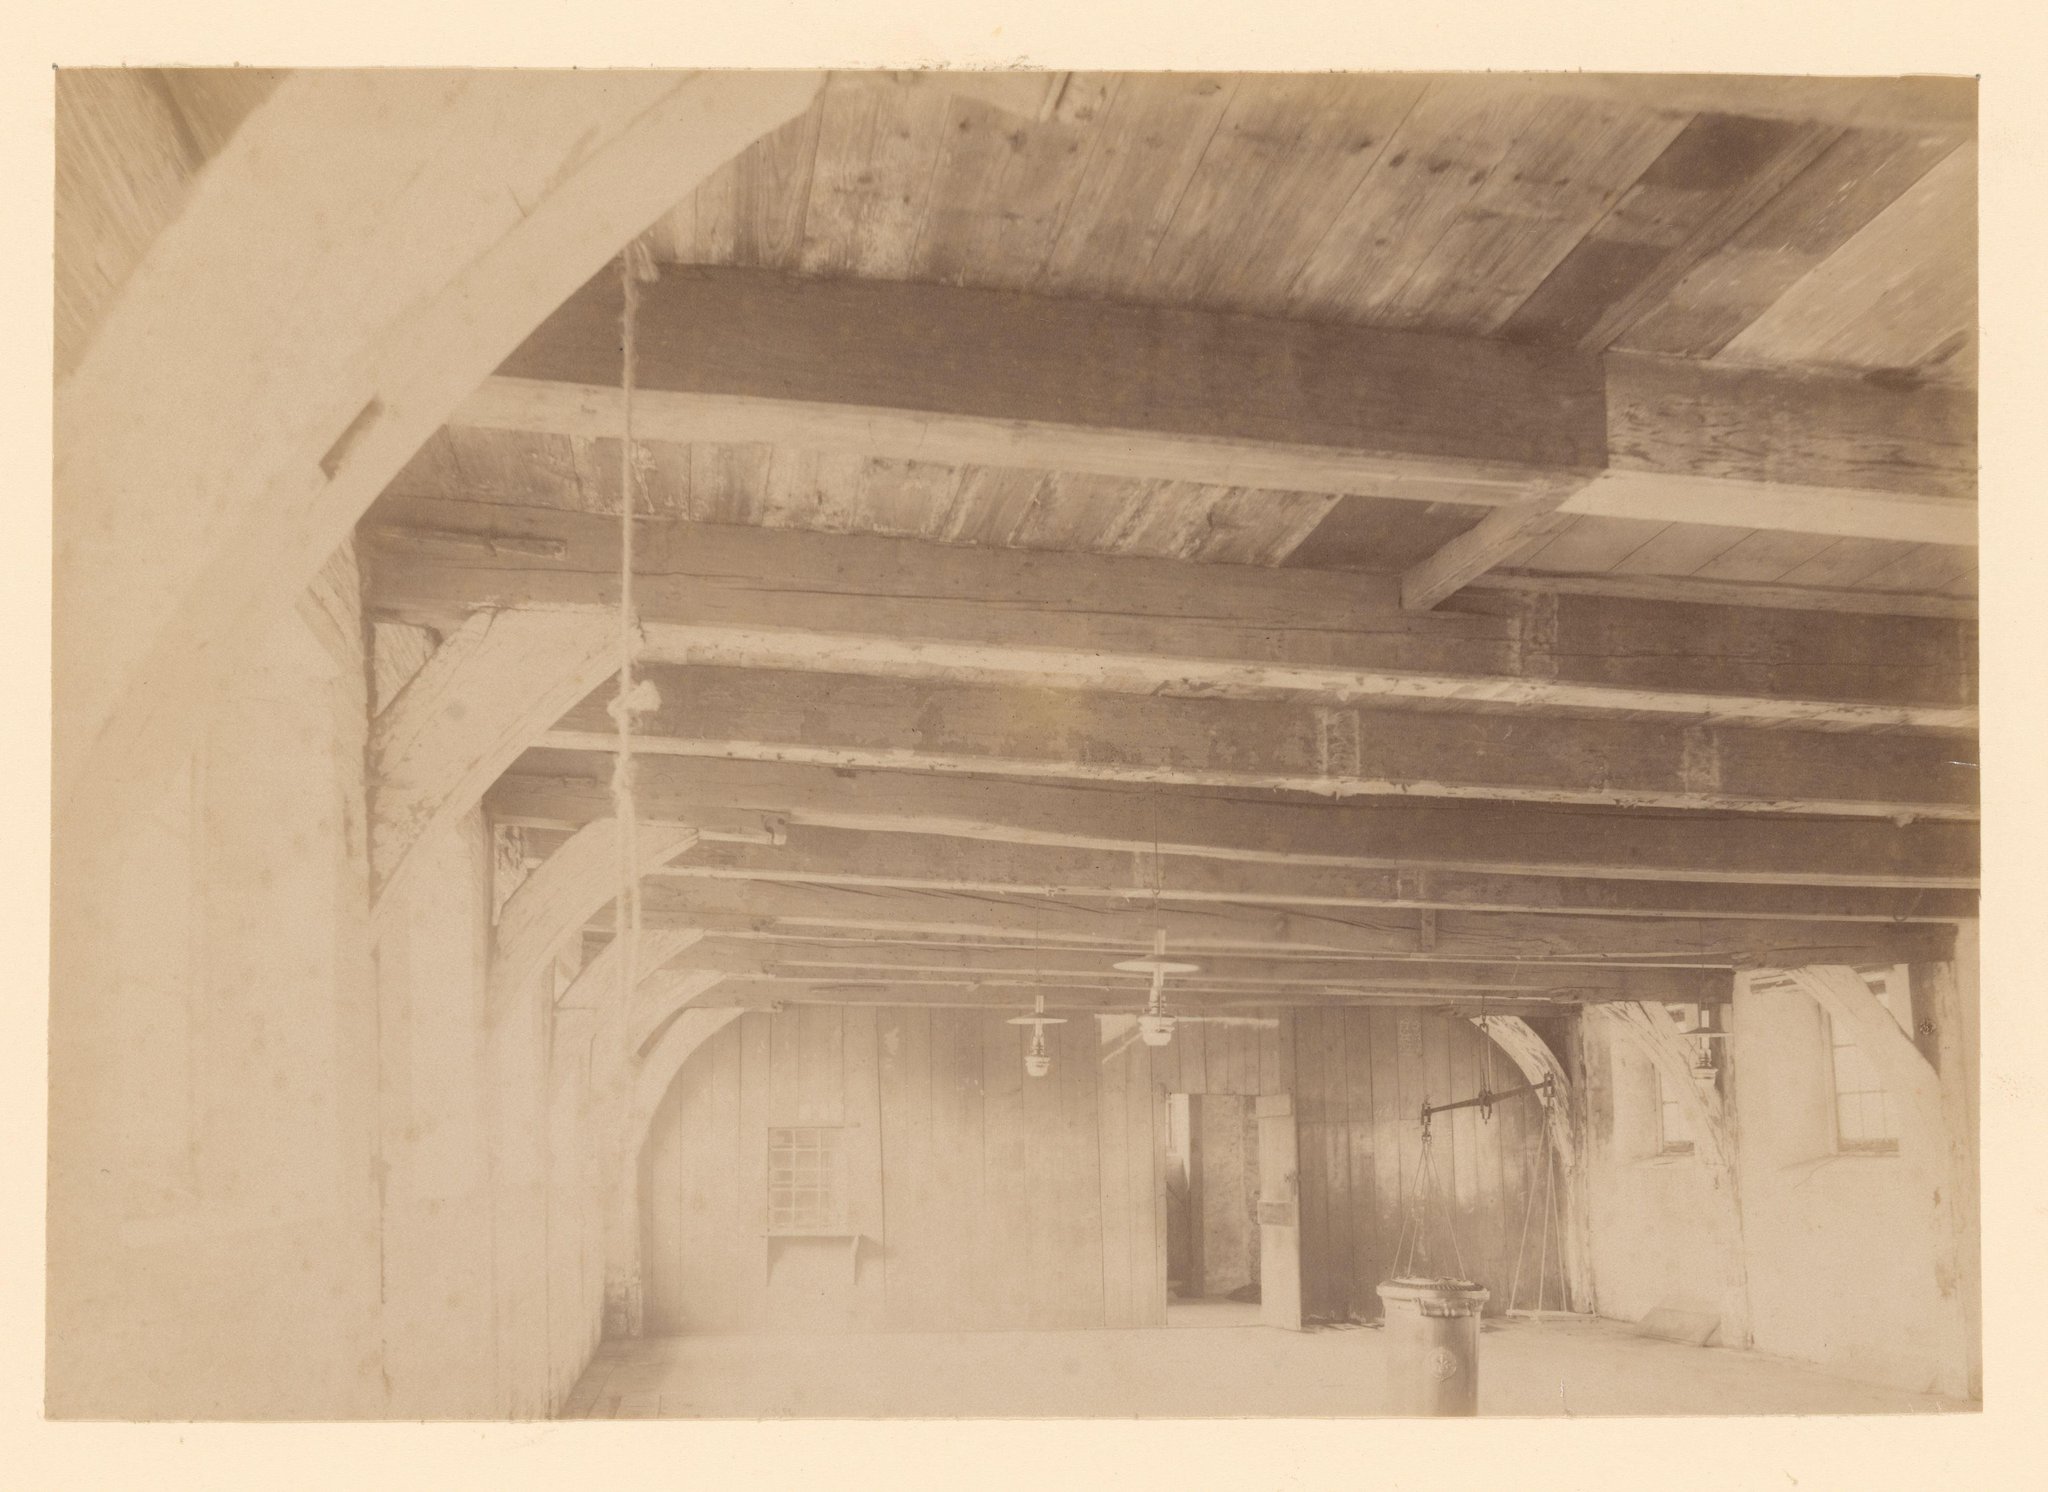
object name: photograph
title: Interieur van de Begijnhofkapel te Bolsward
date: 1902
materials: cardboard, photographic support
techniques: albumen print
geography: bolsward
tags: parts of church exterior and annexes: chapel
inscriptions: annotation: ‘Bolsward (Fr) / Begijnenhofkapel / Interieur / april 1902’, annotation: ‘Bolsward’